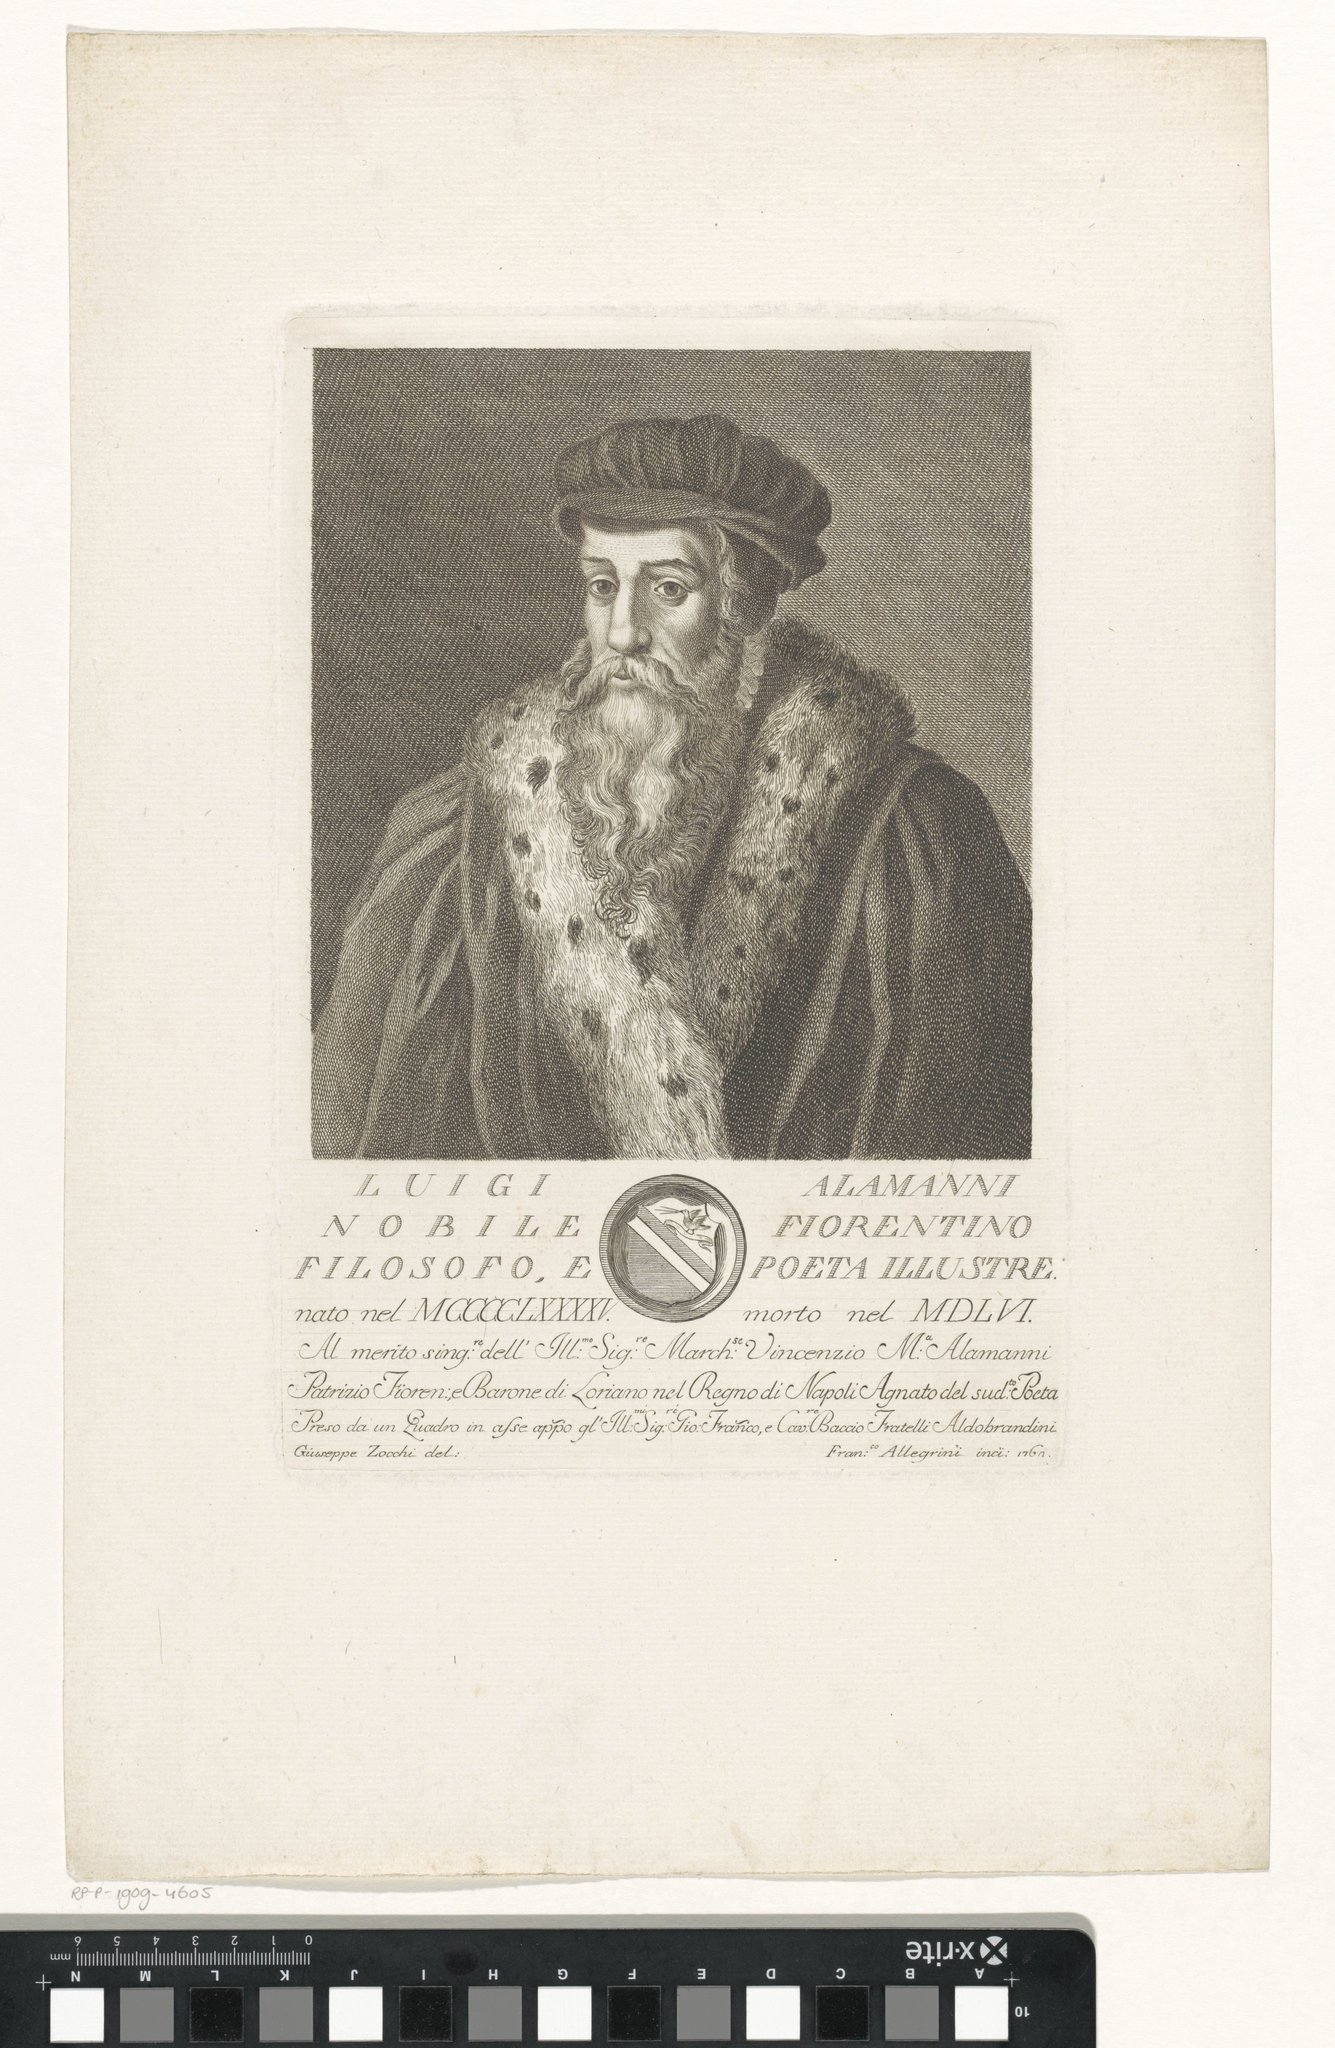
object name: print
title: Portretten van beroemde Italianen met wapenschild in ondermarge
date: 1762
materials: paper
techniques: engraving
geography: italy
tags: historical persons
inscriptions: collector's mark: Lugt 2228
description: Deze prent maakt deel uit van een reeks portretprenten van onbekende omvang. De prenten zijn gemaakt door meedere prentmakers, onder wie Francesco Allegrini en Carlo en Raimondo Faucci.